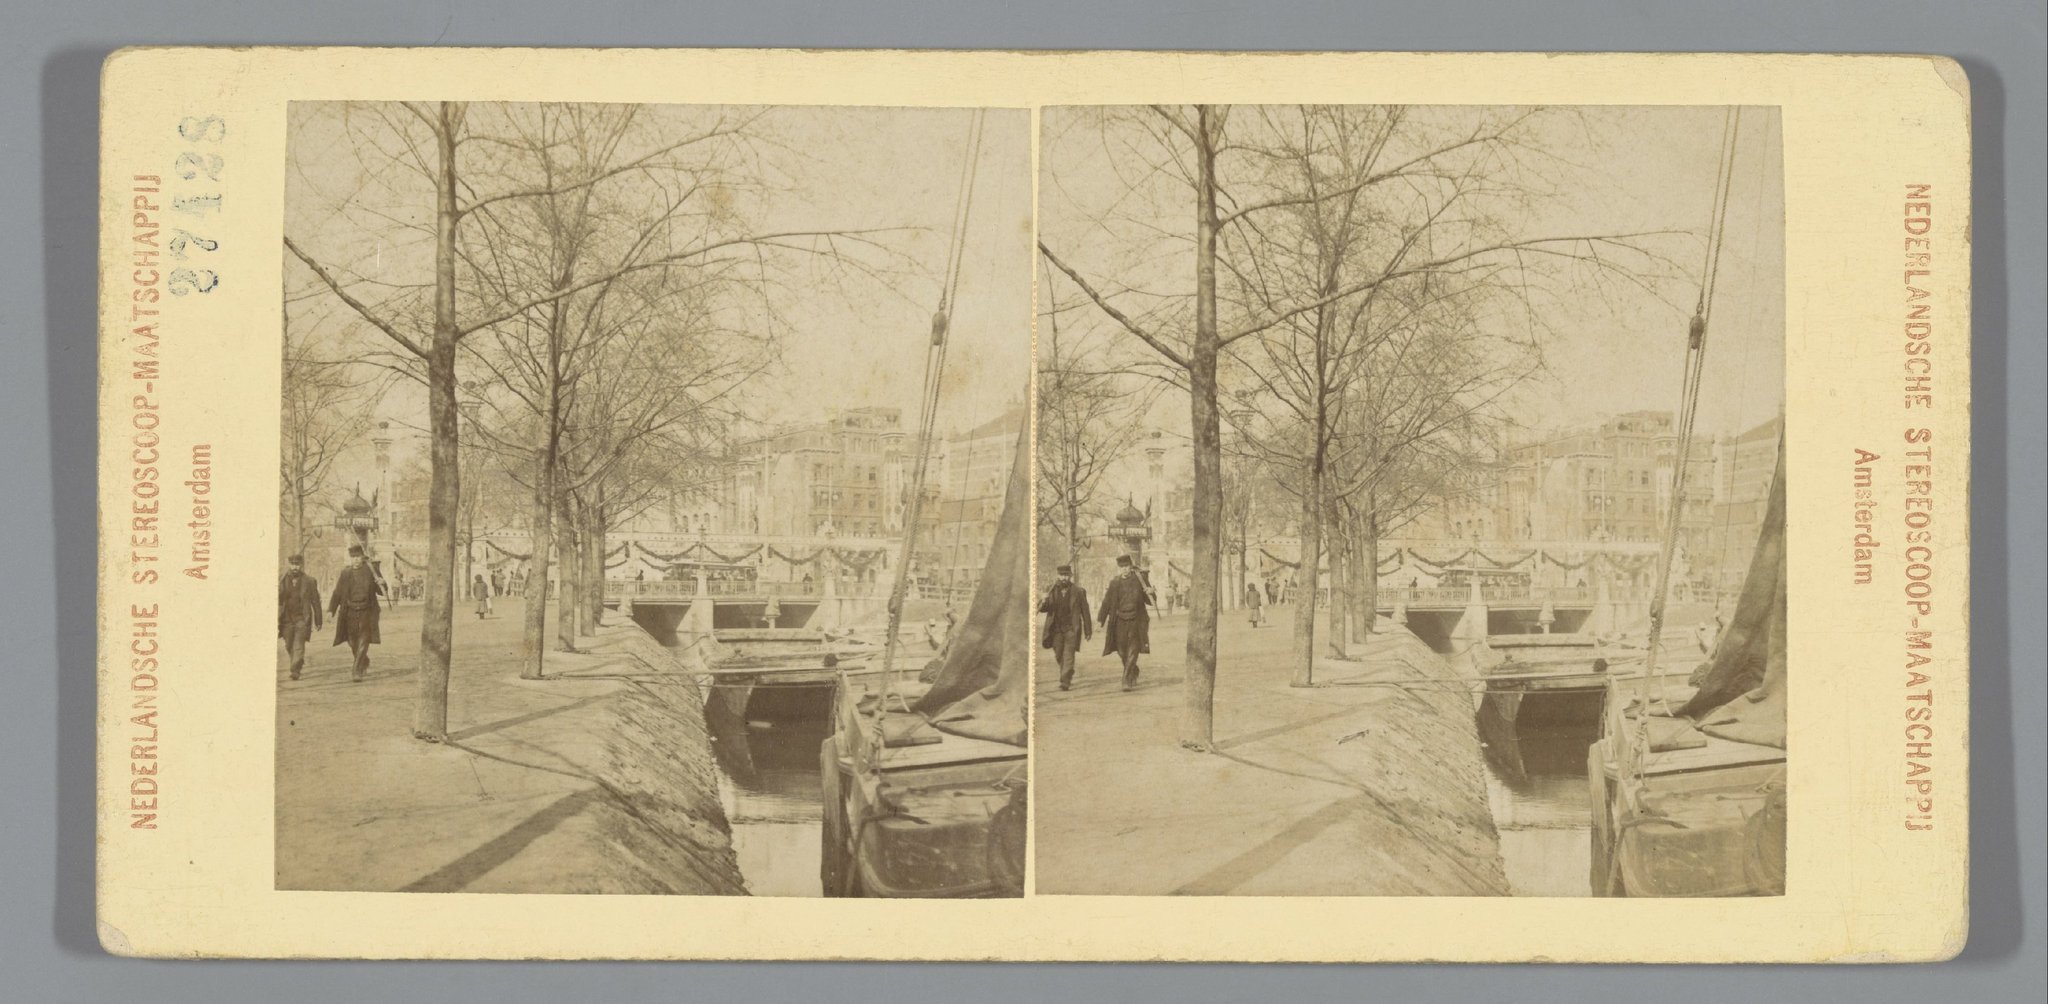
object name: stereograph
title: Stadhouderskade met op de achtergrond de Leidsebrug en het American Hotel, Amsterdam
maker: j.g. beers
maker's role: fotograaf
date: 1901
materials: cardboard, paper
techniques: albumen print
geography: amsterdam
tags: bridge in city across river, canal, etc.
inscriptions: number: ‘27428’, inscription: ‘Amsterdam/ Stadhouderskade/ met gezicht op het/ oude American Hotel’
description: De versieringen op de Leidsebrug zijn aangebracht ter gelegenheid van het huwelijk tussen koningin Wilhelmina en prins Hendrik.